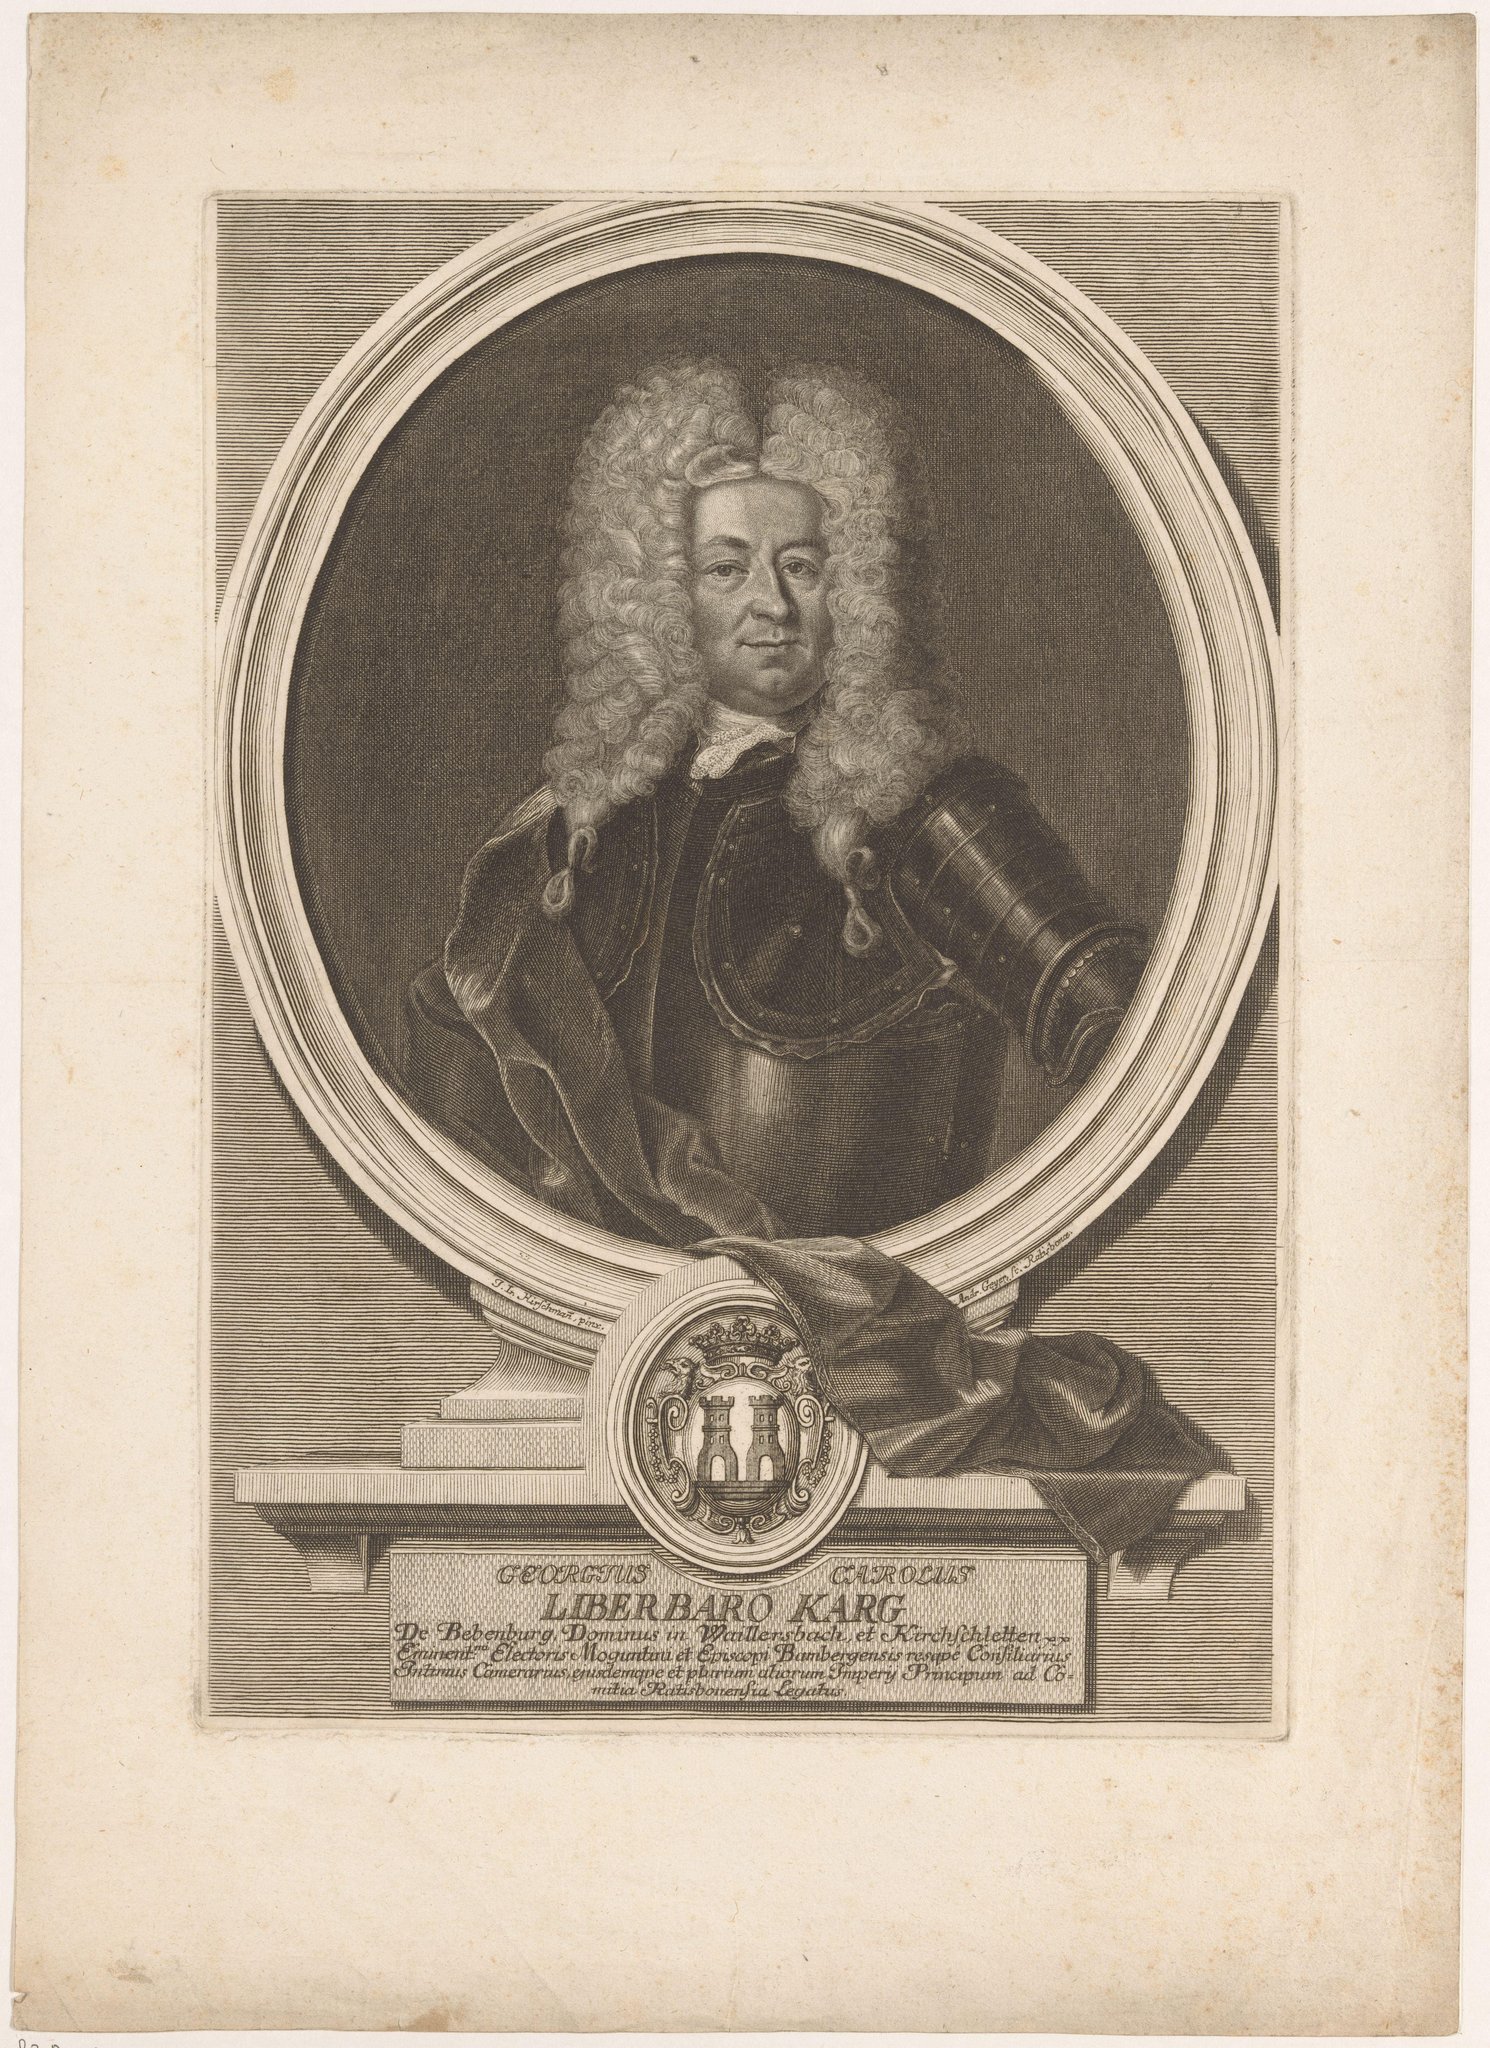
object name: print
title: Portret van Georg Carl Karg von Bebenburg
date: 1696-1729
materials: paper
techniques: engraving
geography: regensburg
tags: ornament ~ medallion, armour, historical persons, armorial bearing, heraldry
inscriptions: collector's mark: Lugt 2228